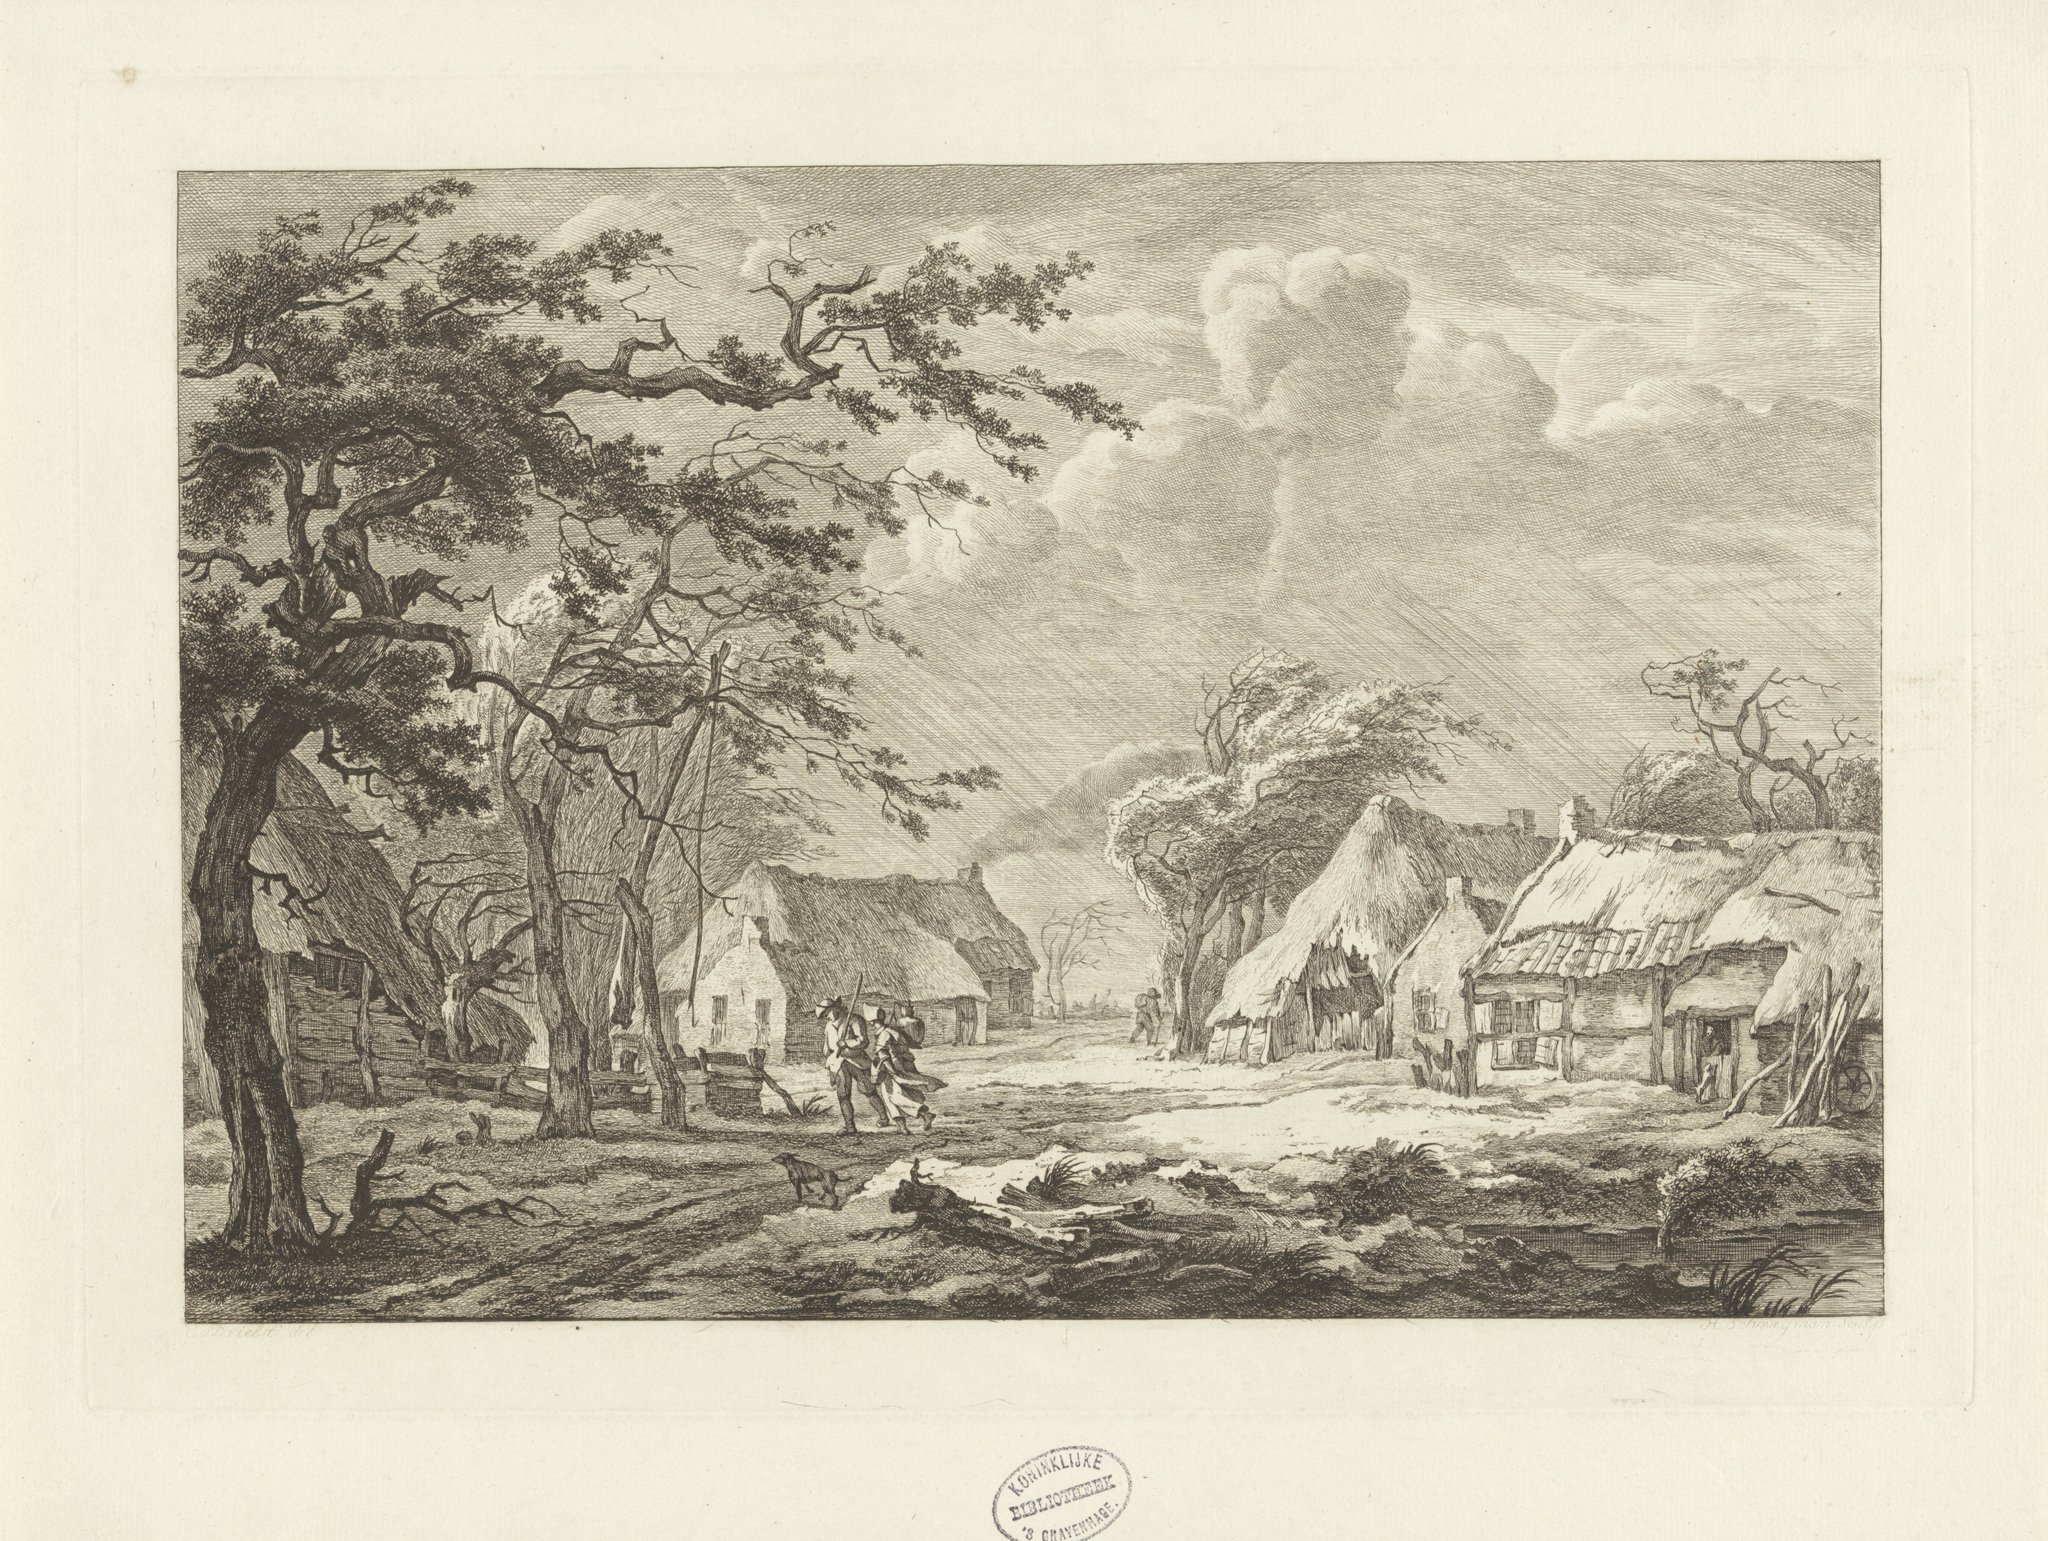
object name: print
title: IX Gezichten in en bij het landschap Drenthe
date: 1771-1816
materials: paper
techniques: engraving, etching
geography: anloo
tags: village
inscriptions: collector's mark: Lugt 2228, collector's mark: Lugt 1097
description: Gezicht op enkele boerderijen in Anloo, Drenthe, terwijl het regent en waait. Op de voorgrond een man, vrouw en hond.